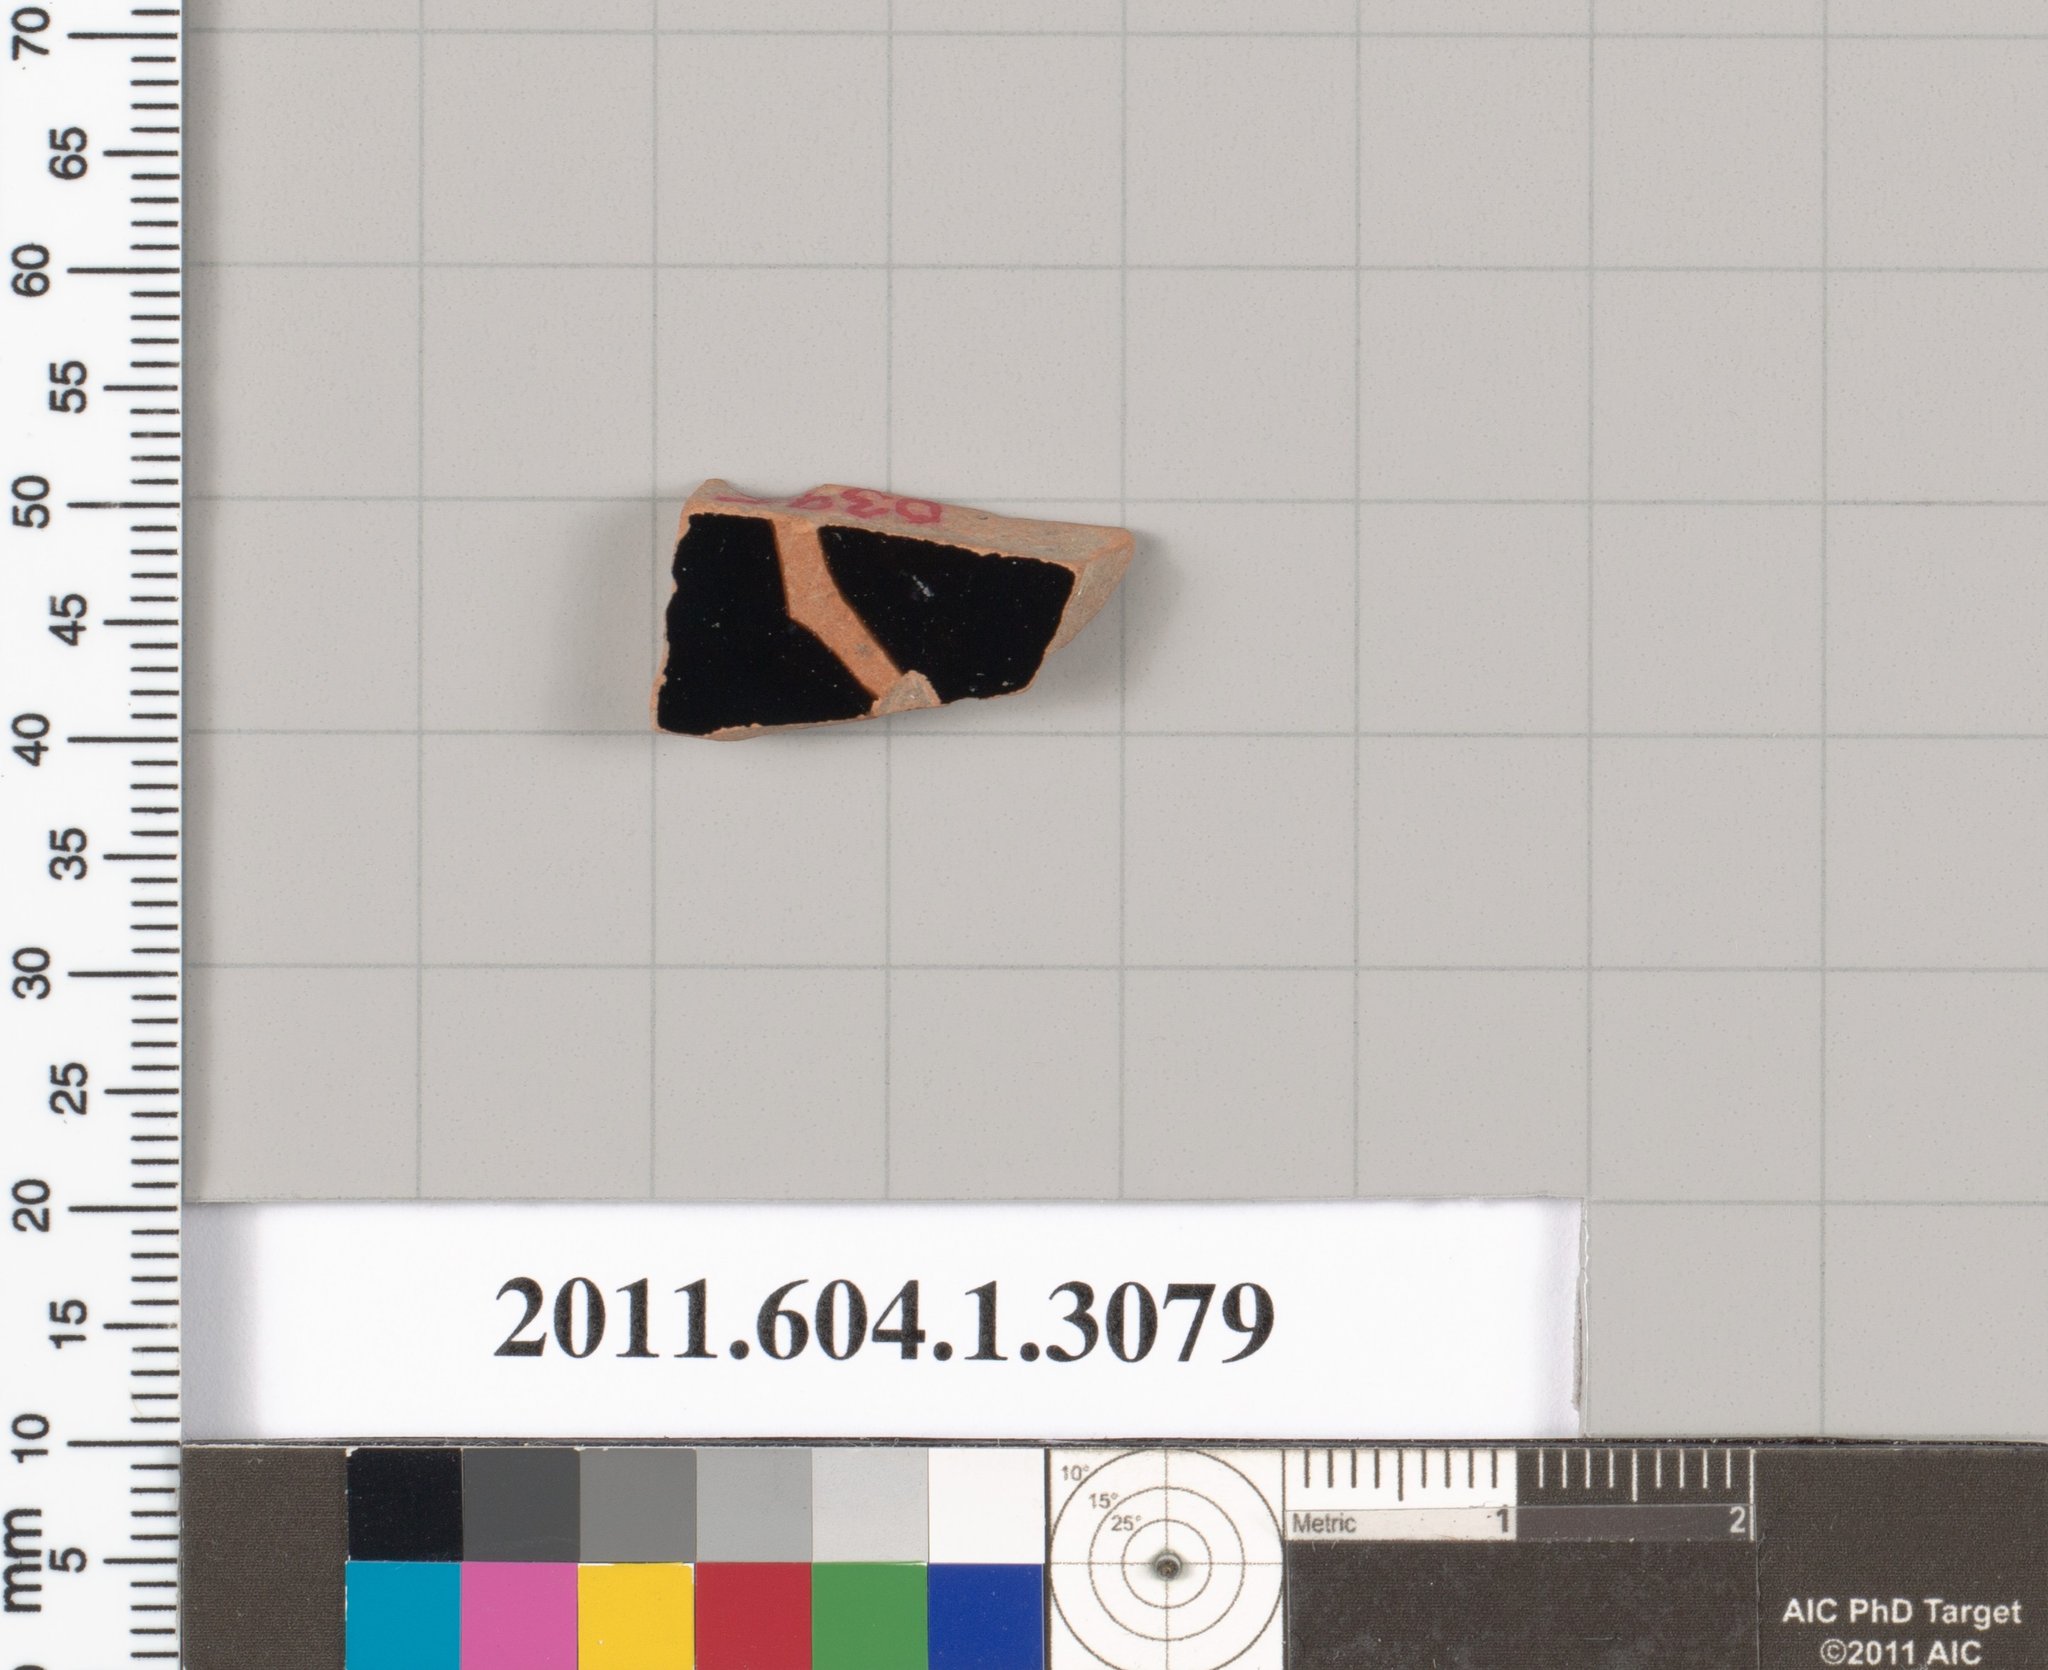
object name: kylix fragment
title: Terracotta fragment of a kylix (drinking cup)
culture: greek, attic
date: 490-480 BCE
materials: terracotta